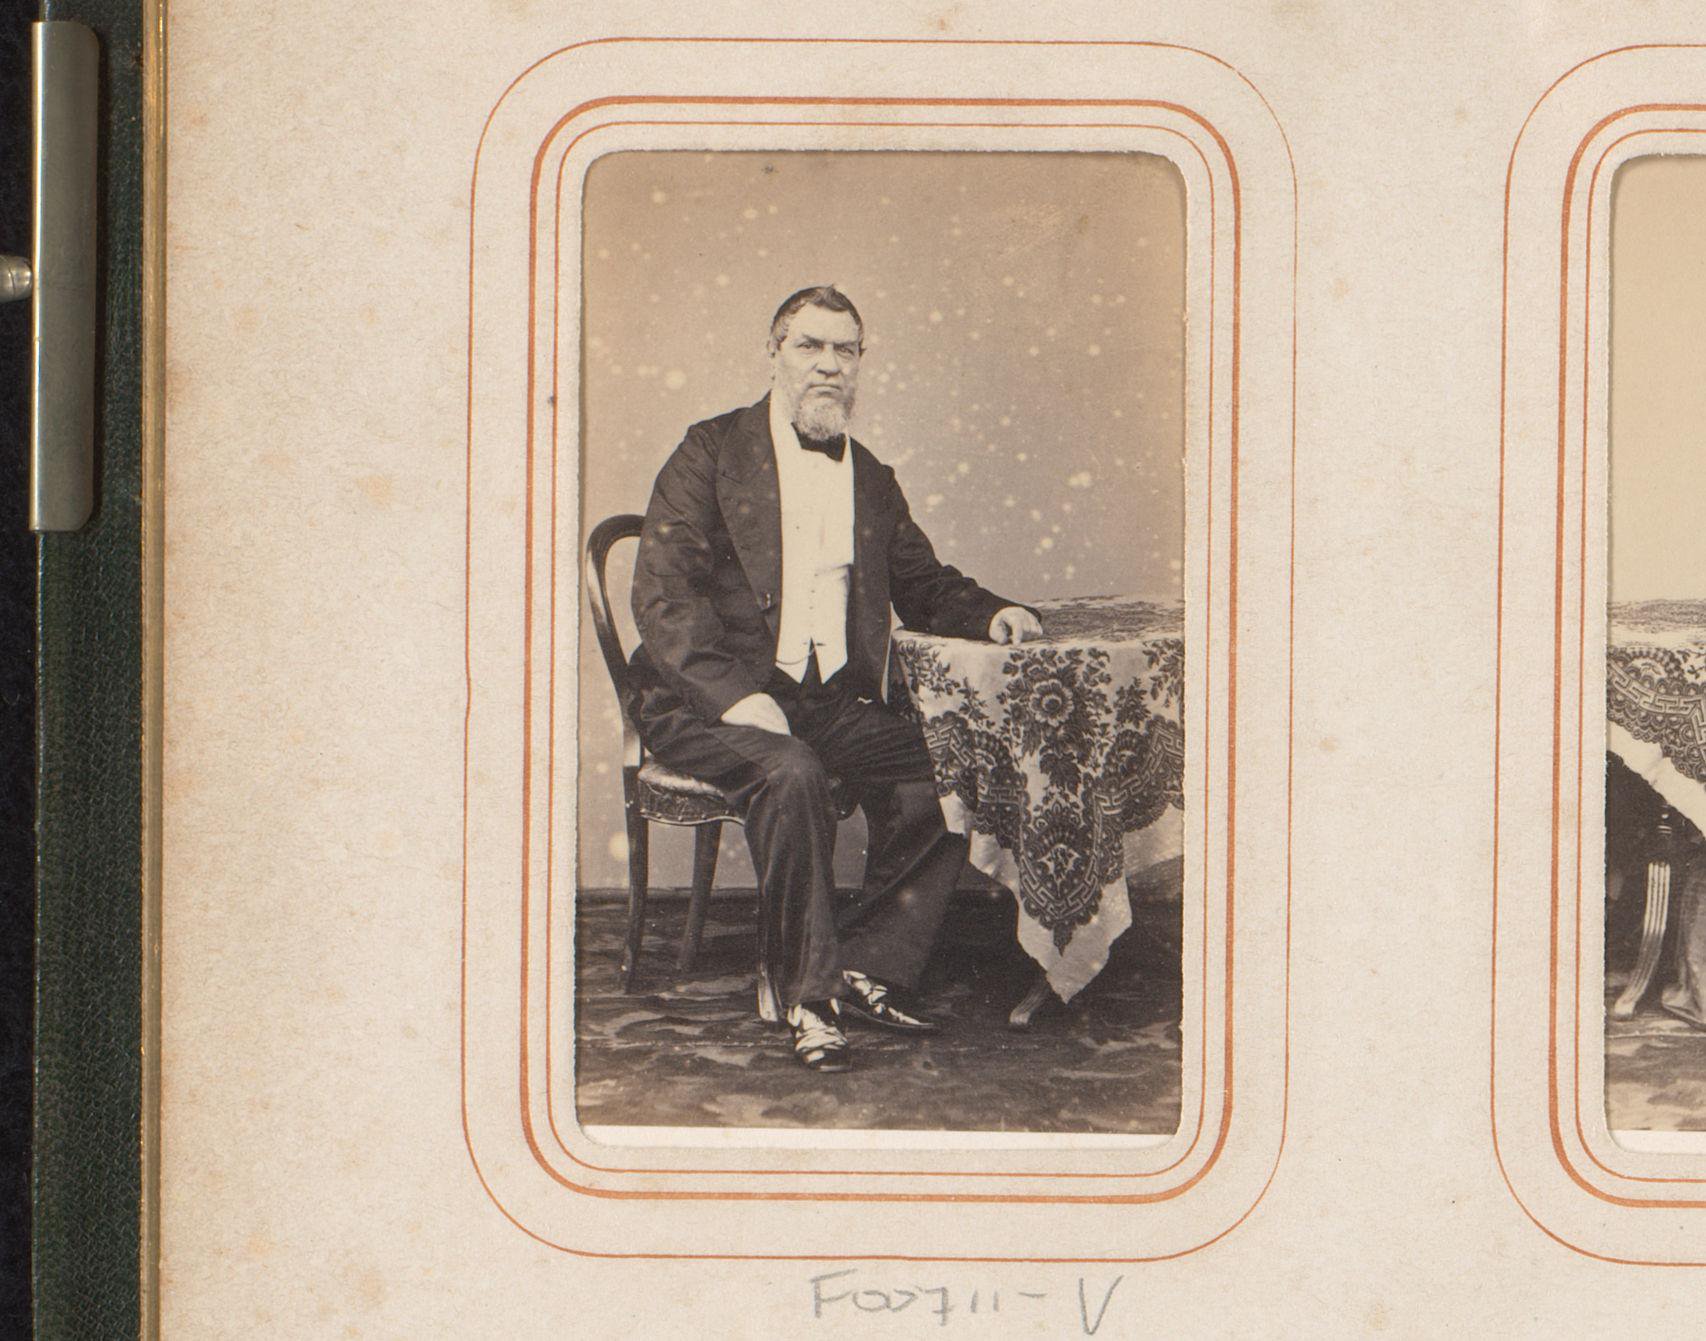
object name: carte de visite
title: Portret van een zittende man met baard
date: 1855-1910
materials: cardboard, photographic support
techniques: albumen print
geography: java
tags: historical persons, beard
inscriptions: inscription: ‘Woodbury & Page,/ Photographers/ Java’